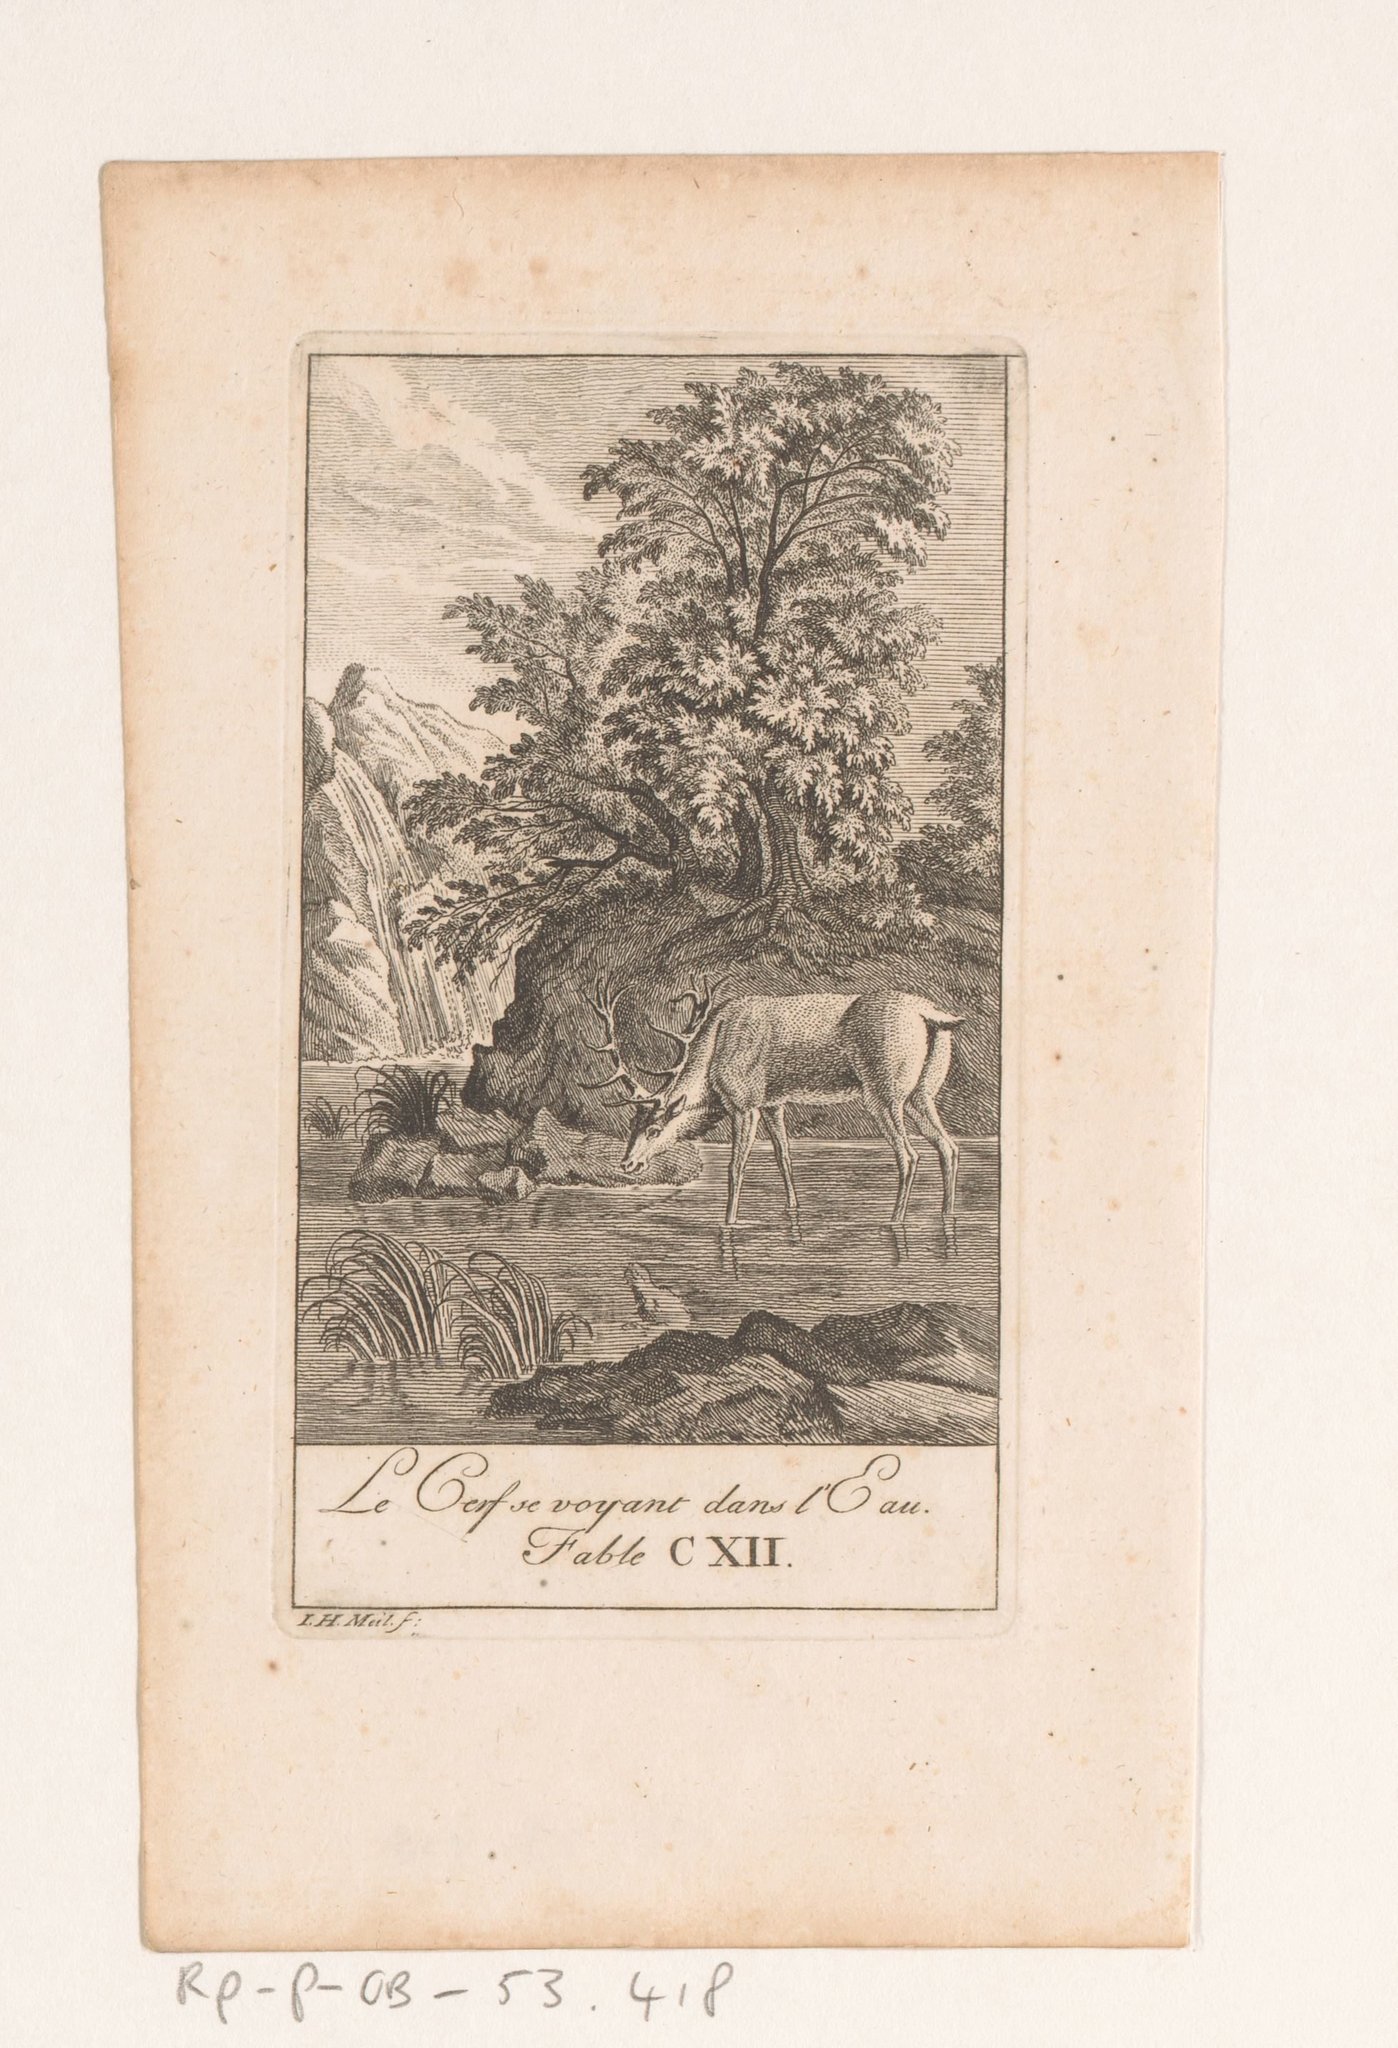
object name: book illustration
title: Le cerf voyant dans l'eau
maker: johann heinrich meil (der ältere)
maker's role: print maker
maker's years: 1730-1820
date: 1758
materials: paper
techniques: etching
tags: fables of lafontaine : use 85(...), hoofed animals: deer, landscapes with waters, waterscapes, seascapes (in the temperate zone)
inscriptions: collector's mark: Lugt 2228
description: Illustratie uit: Fontaine, J. de la. Fables choisies, mises en vers. Dl. 2. Dresden & Leipzig: George Conrad Walther, 1758.